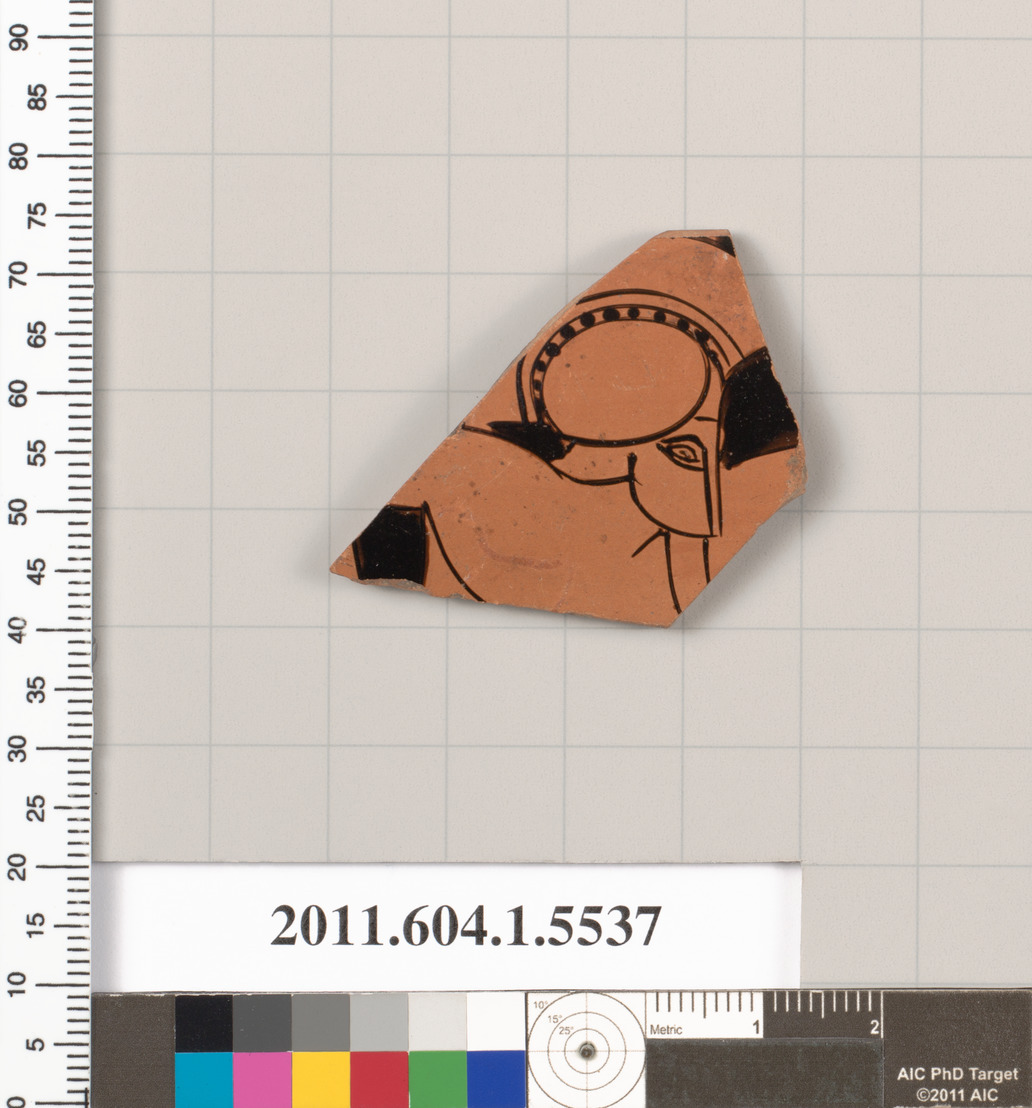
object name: kylix fragment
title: Terracotta rim fragment of a kylix (drinking cup)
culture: greek, attic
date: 520-510 BCE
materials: terracotta